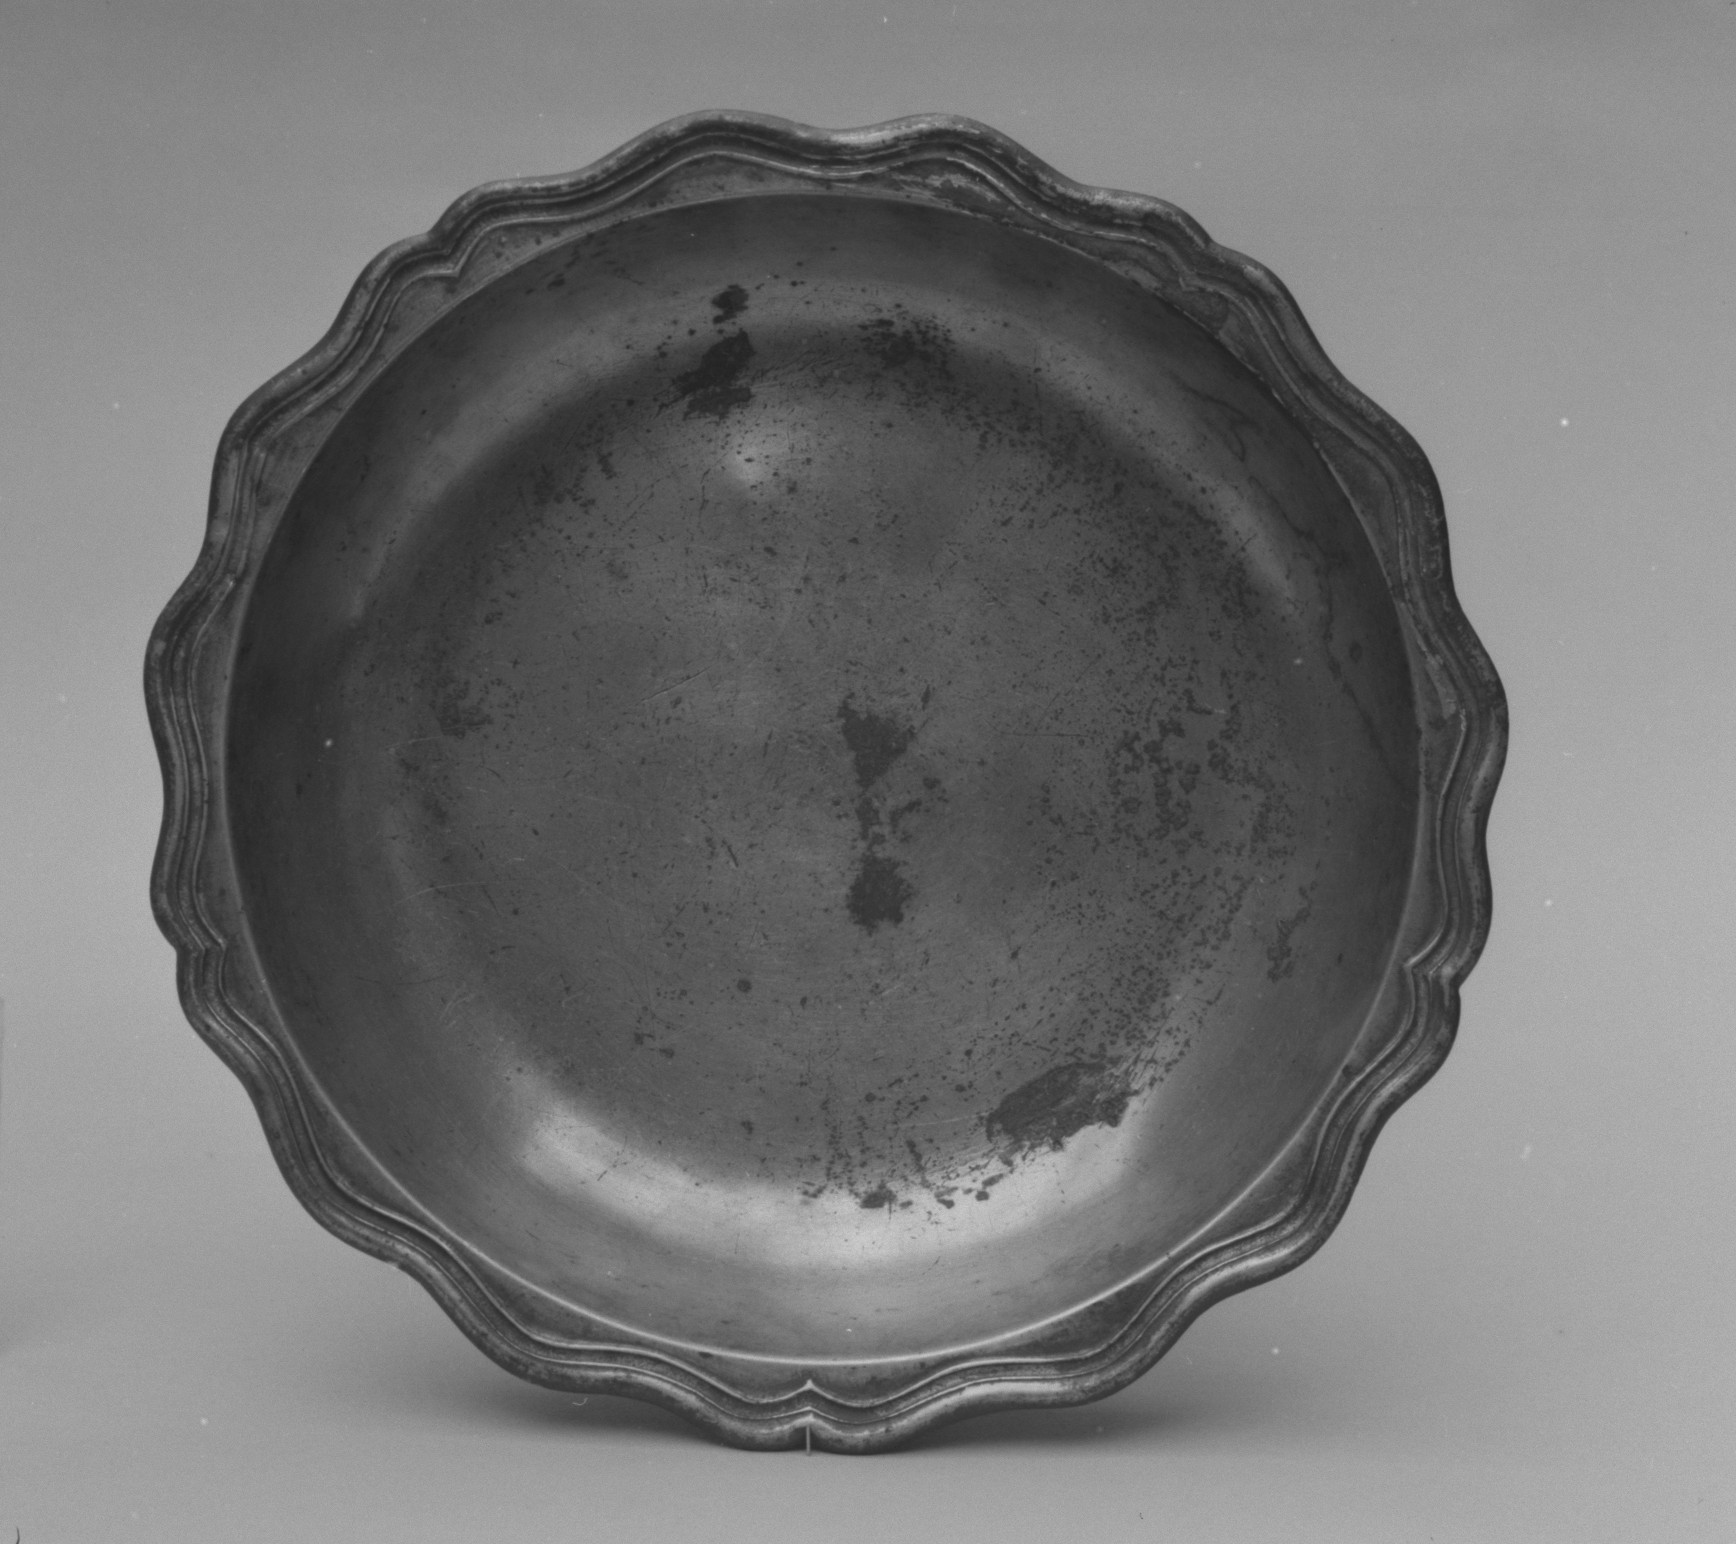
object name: dish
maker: jean-jacques bruckner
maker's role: artist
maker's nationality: german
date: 1701-1800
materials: pewter